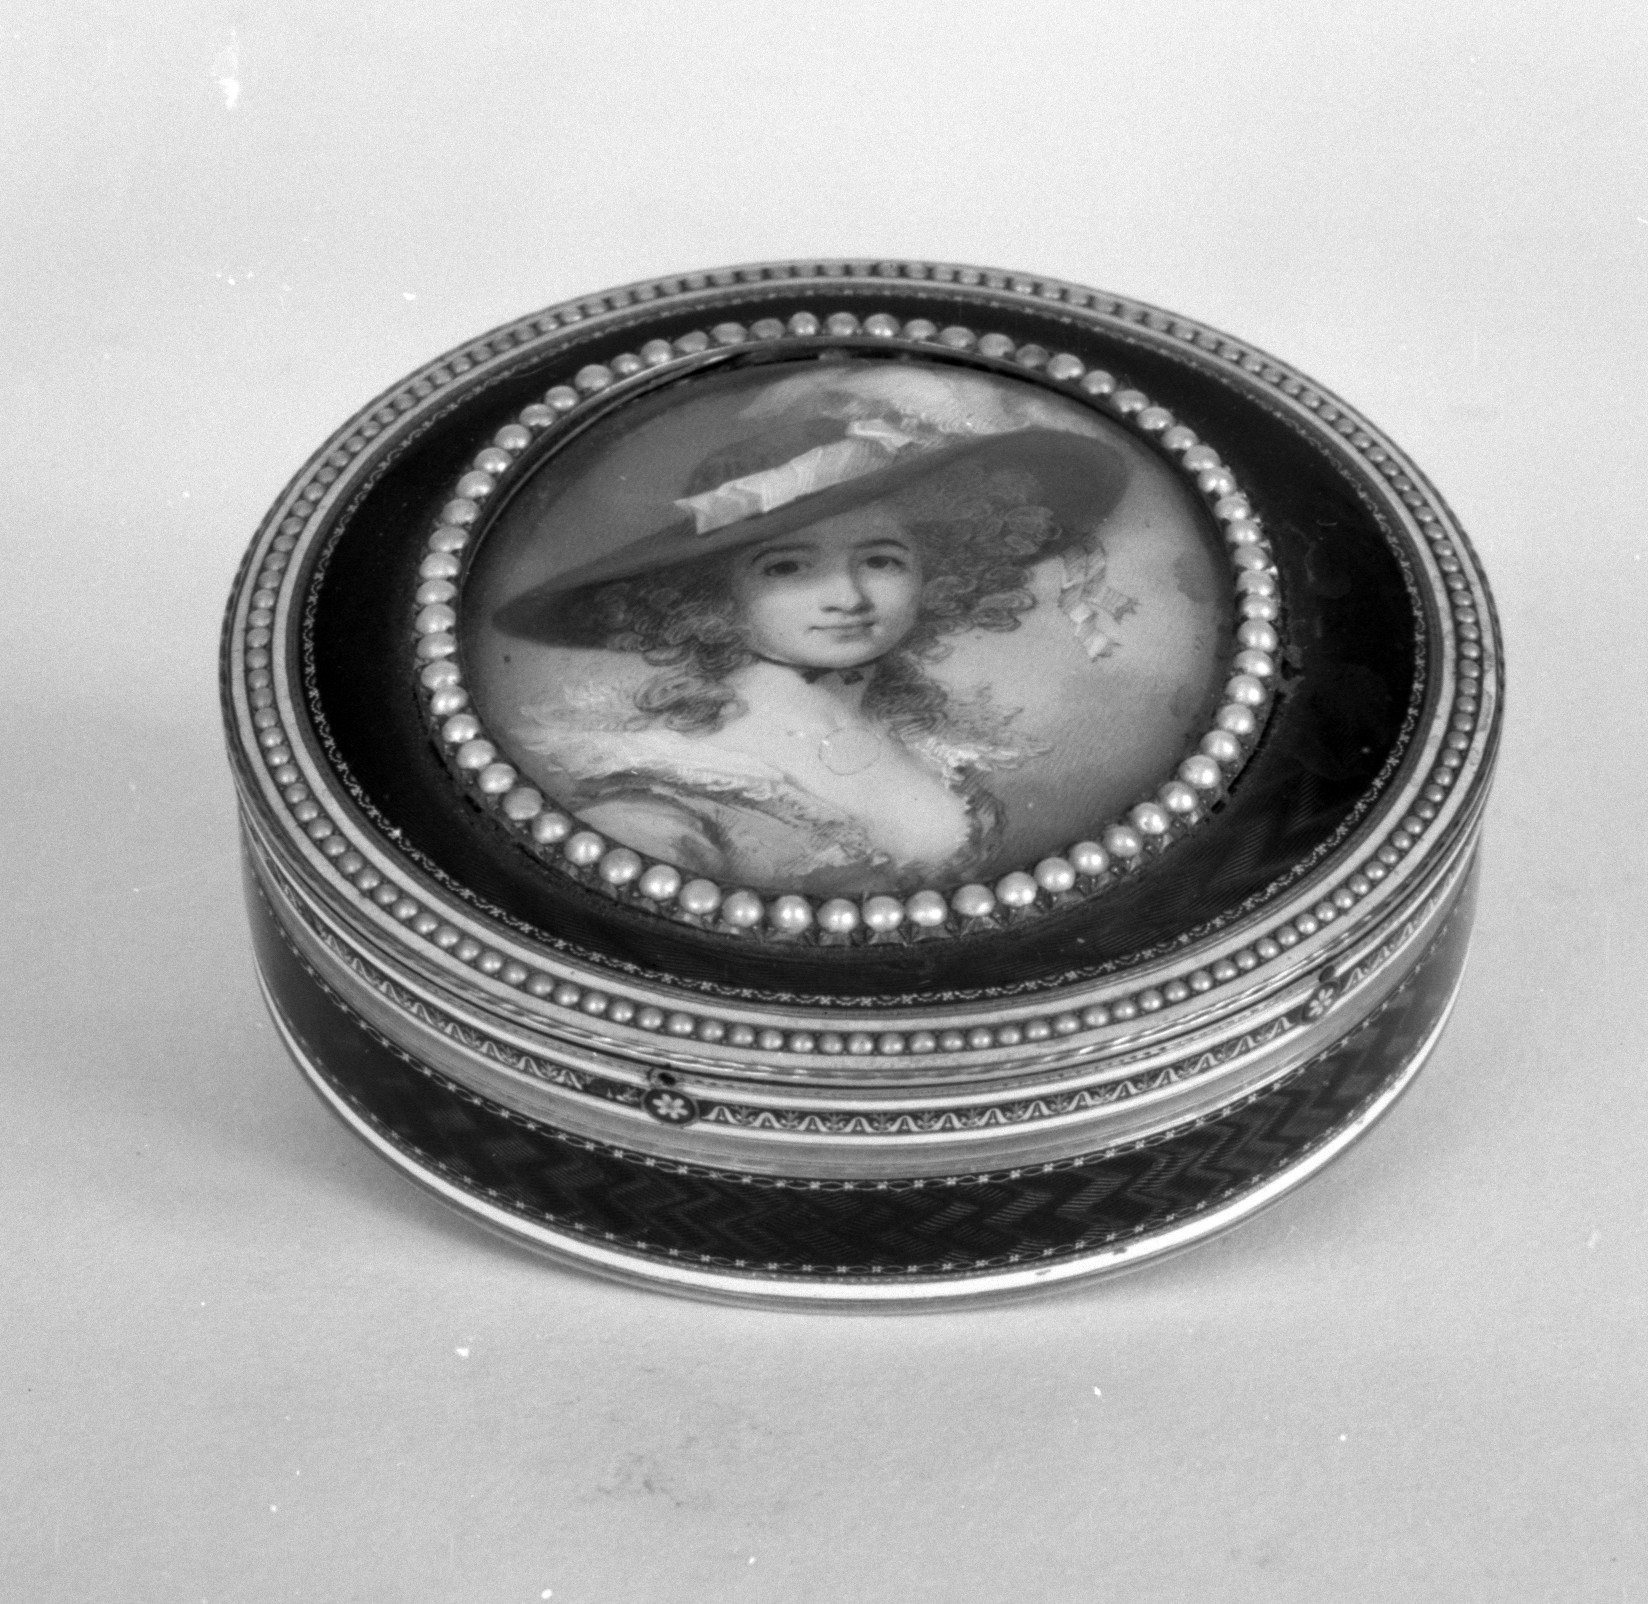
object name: snuffbox, painting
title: Snuffbox with portrait of a woman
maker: g.r.c.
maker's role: maker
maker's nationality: swiss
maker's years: 1740-1830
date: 1790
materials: enamel, gold, ivory, pearl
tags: portraits,women